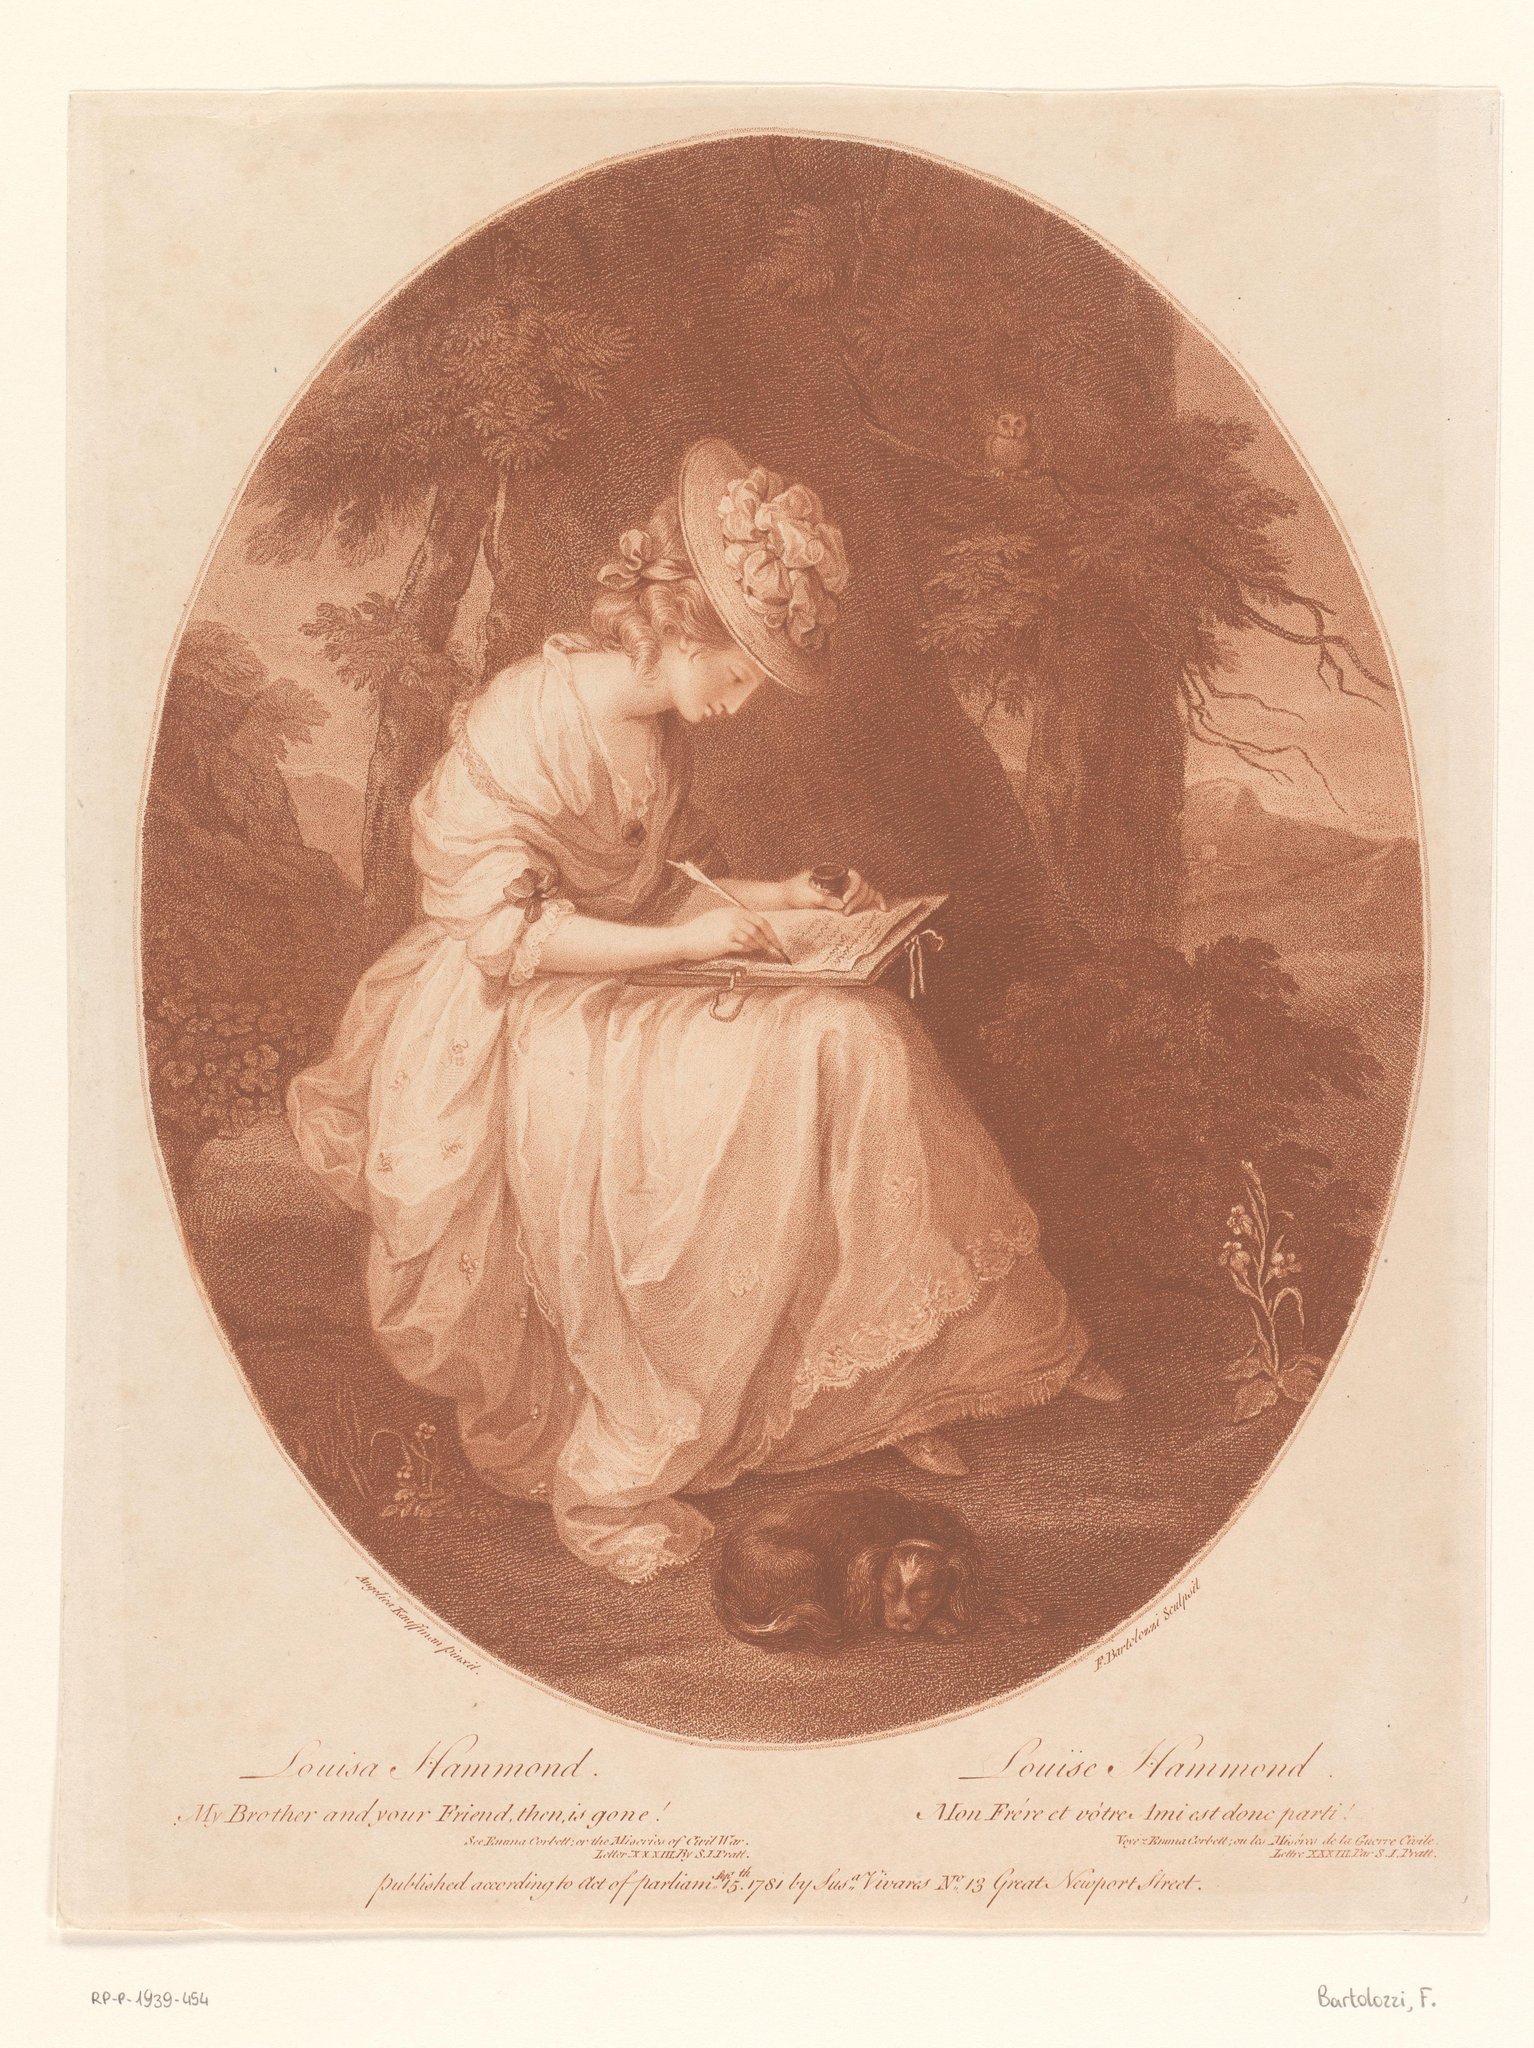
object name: print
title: Louisa Hammond schrijvend onder een boom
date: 1781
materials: paper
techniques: etching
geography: london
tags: handwriting, writing as activity, trees, writing boards, owls, female literary characters, dog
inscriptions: collector's mark: Lugt 2760, collector's mark: Lugt 2166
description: Personage uit 'Emma Corbett, or the Miseries of Civil War' van Samuel Jackson Pratt. Met onderschrift in het Engels en Frans.